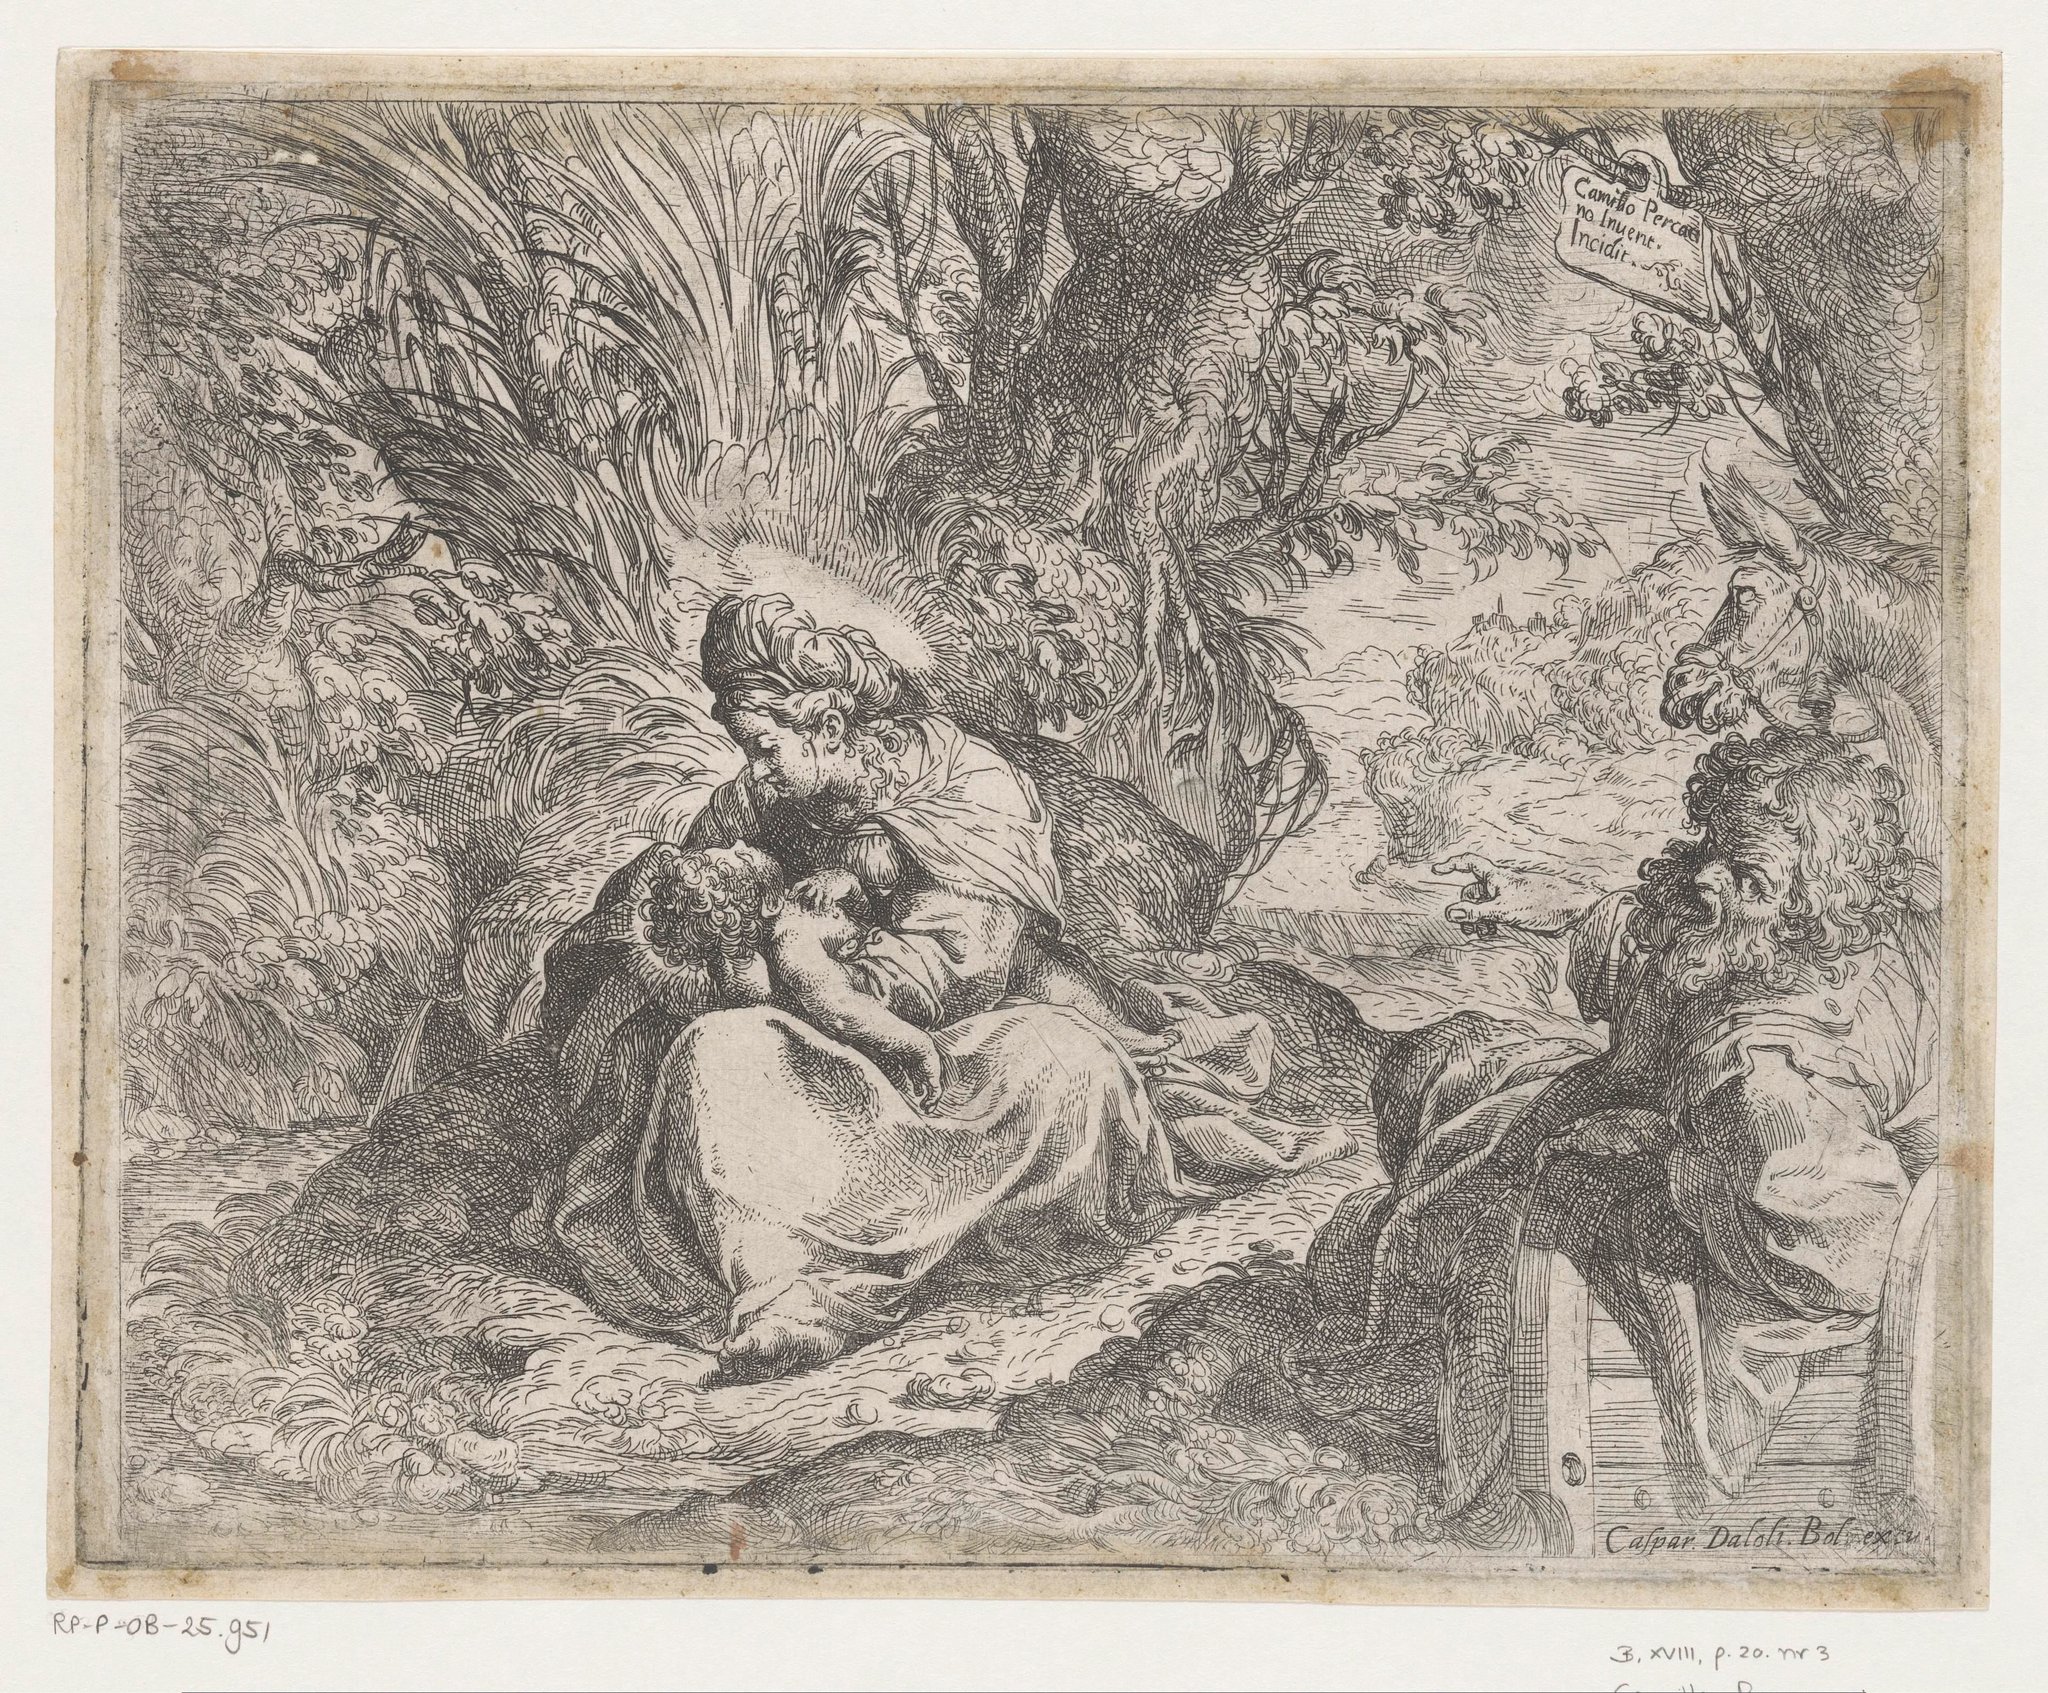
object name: print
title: Rest on the Flight into Egypt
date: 1650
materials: paper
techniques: etching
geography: italy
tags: rest on the flight into egypt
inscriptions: collector's mark: Lugt 240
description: De Heilige Familie zittend in een landschap. Op de voorgrond rechts Jozef die naar de beschouwer kijkt en wijst naar Maria met het Christuskind op schoot.